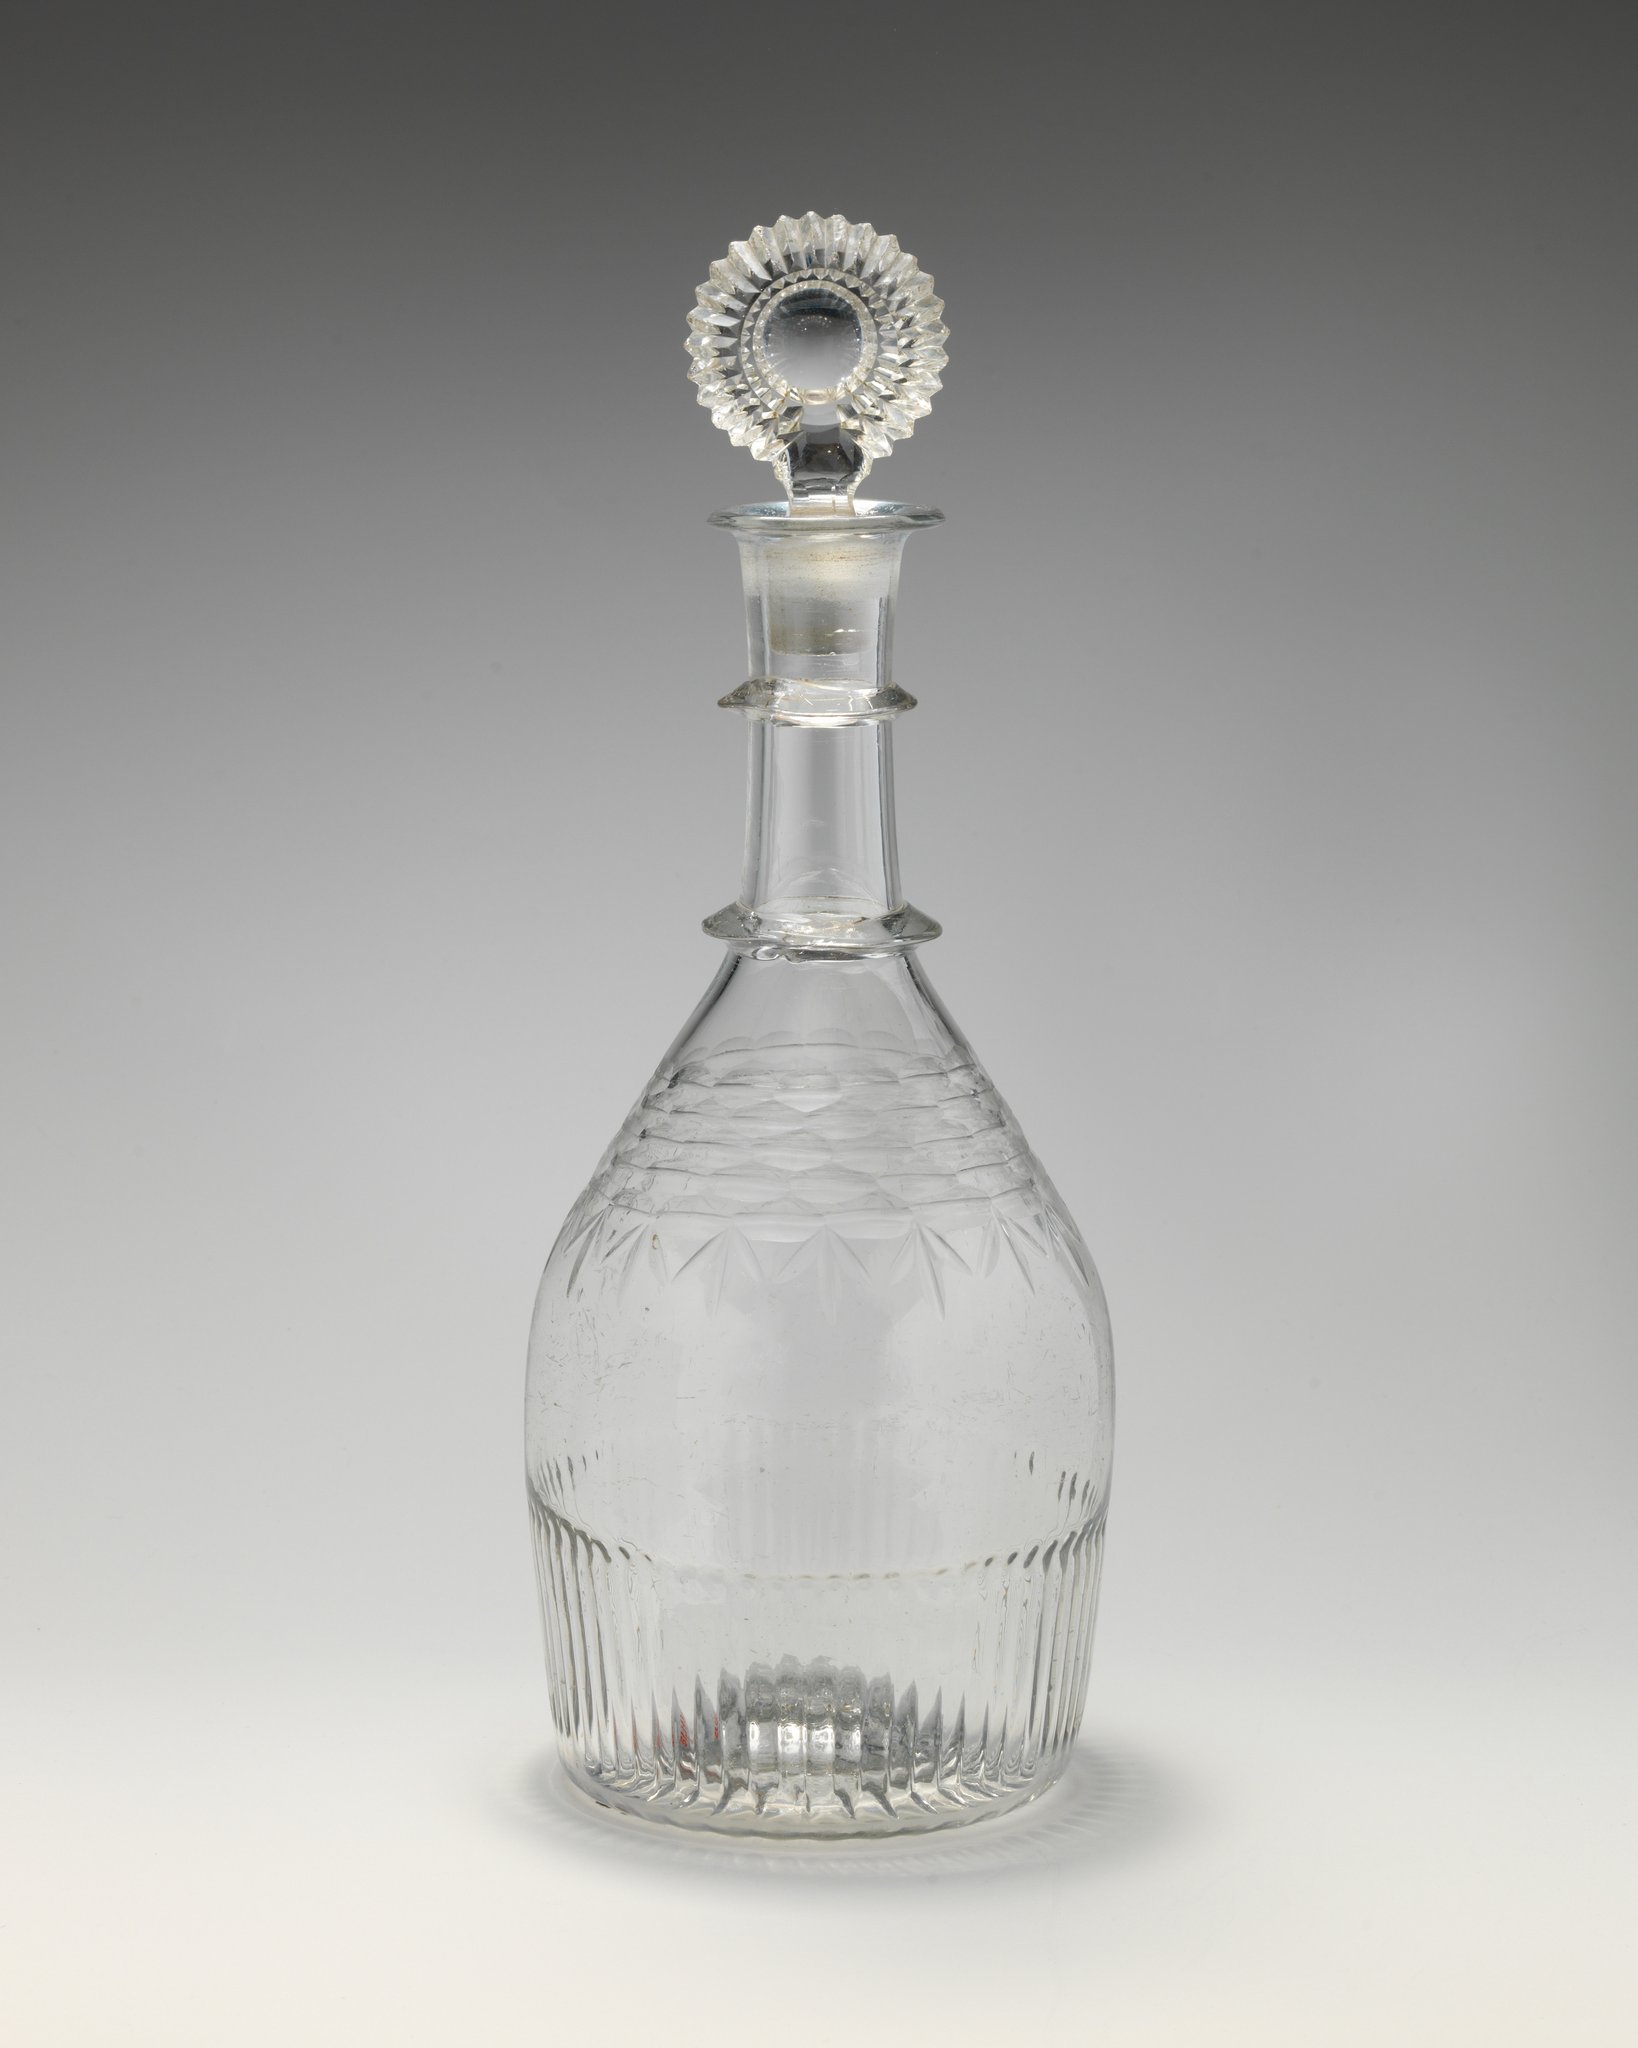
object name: decanter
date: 1801-1833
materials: glass